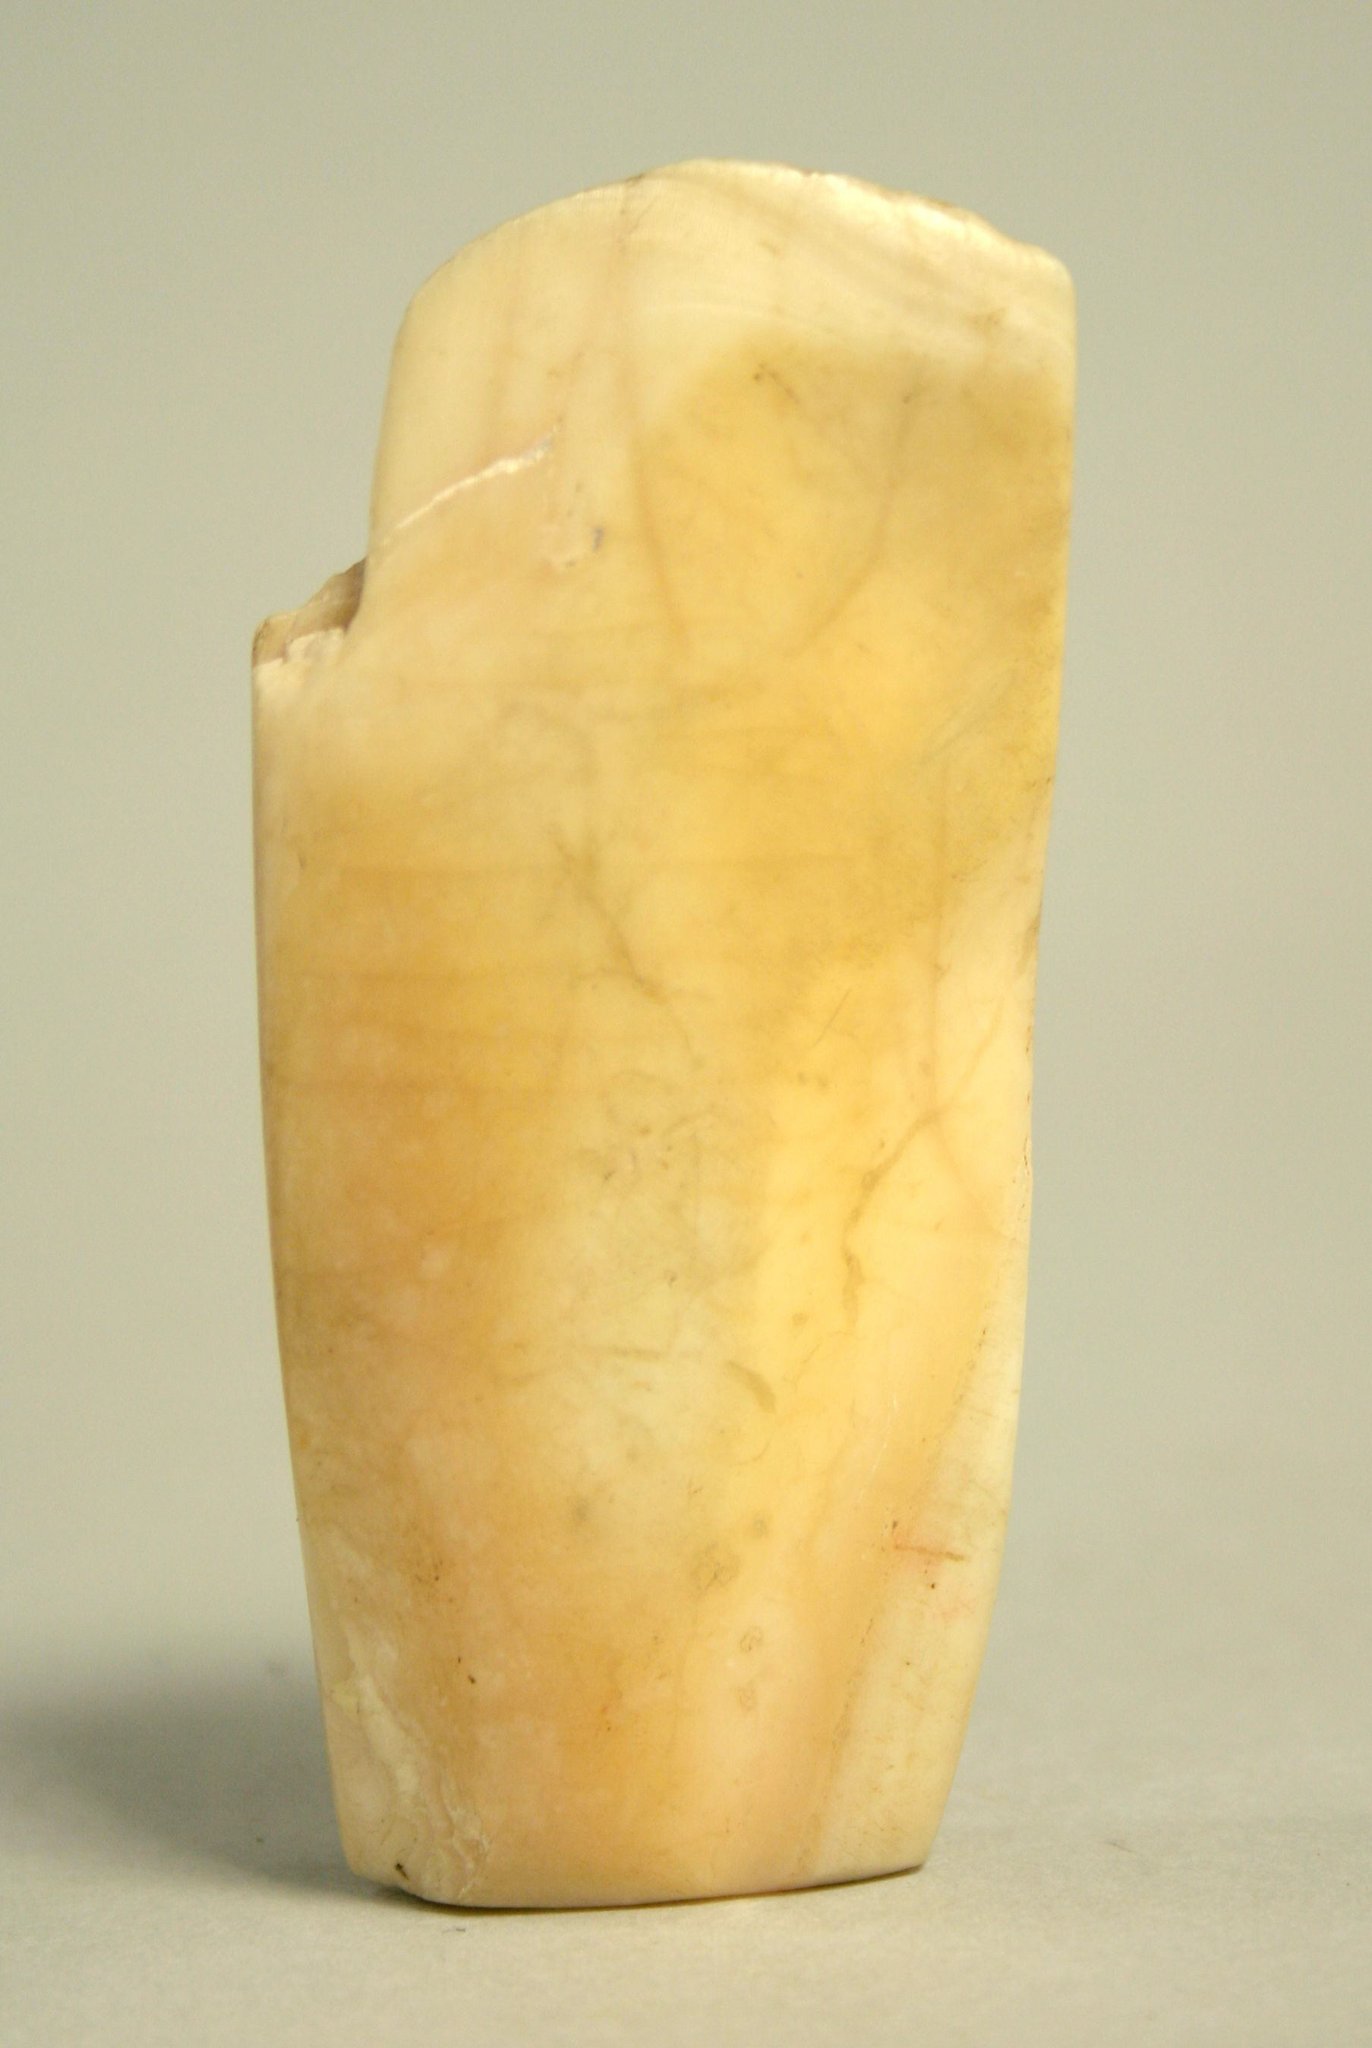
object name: scraper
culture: valdivia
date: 3000-2001 BCE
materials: shell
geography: ecuador